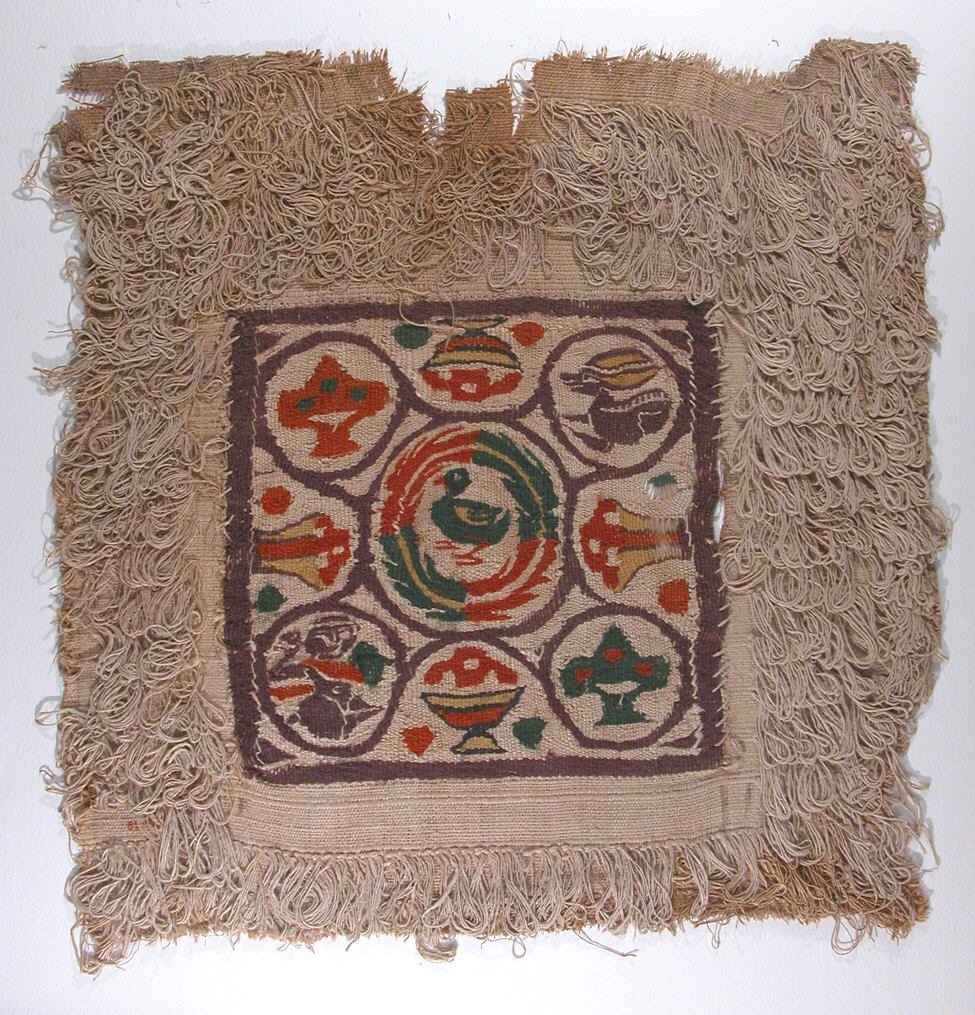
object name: textile fragment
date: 301-500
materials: linen, wool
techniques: weave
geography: egypt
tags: ducks